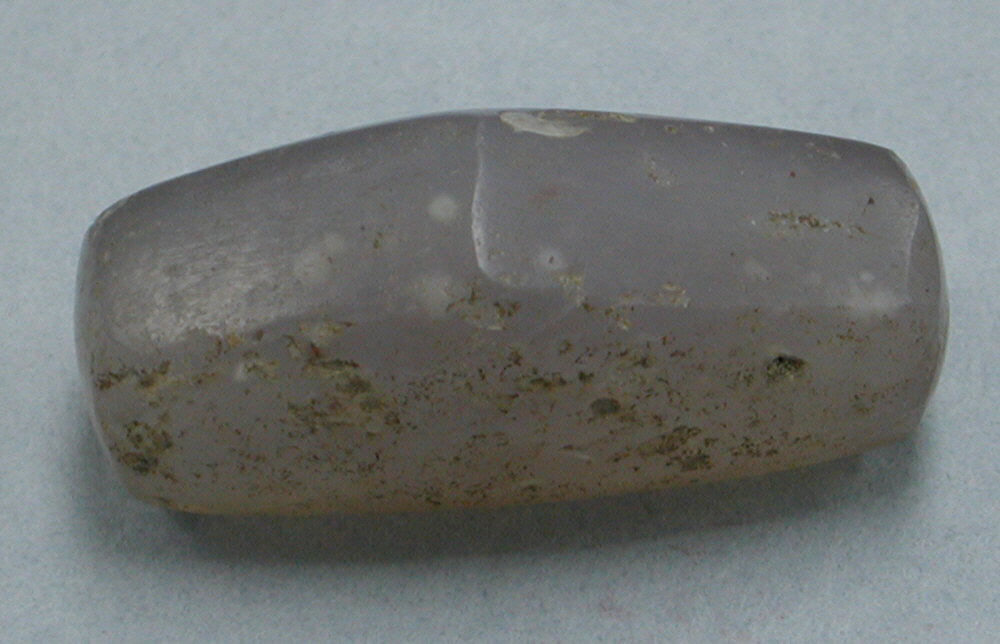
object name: ritual stone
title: Polishing Stone (pulidor)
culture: mexican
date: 1501-1600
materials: stone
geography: mexico